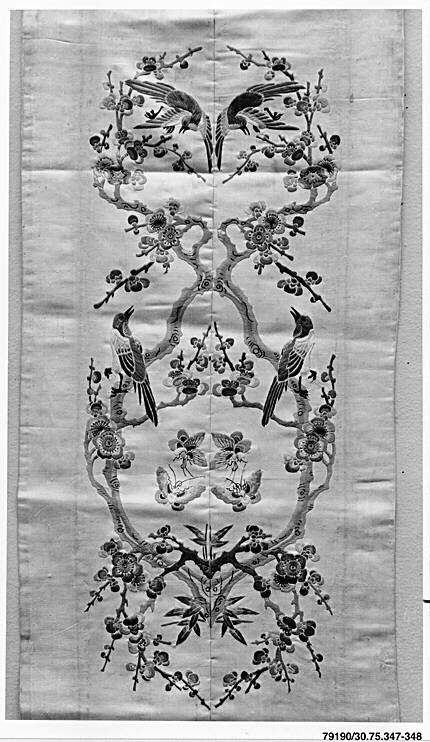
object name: sleeve band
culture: chinese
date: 1801-1900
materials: silk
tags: birds,butterflies,flowers